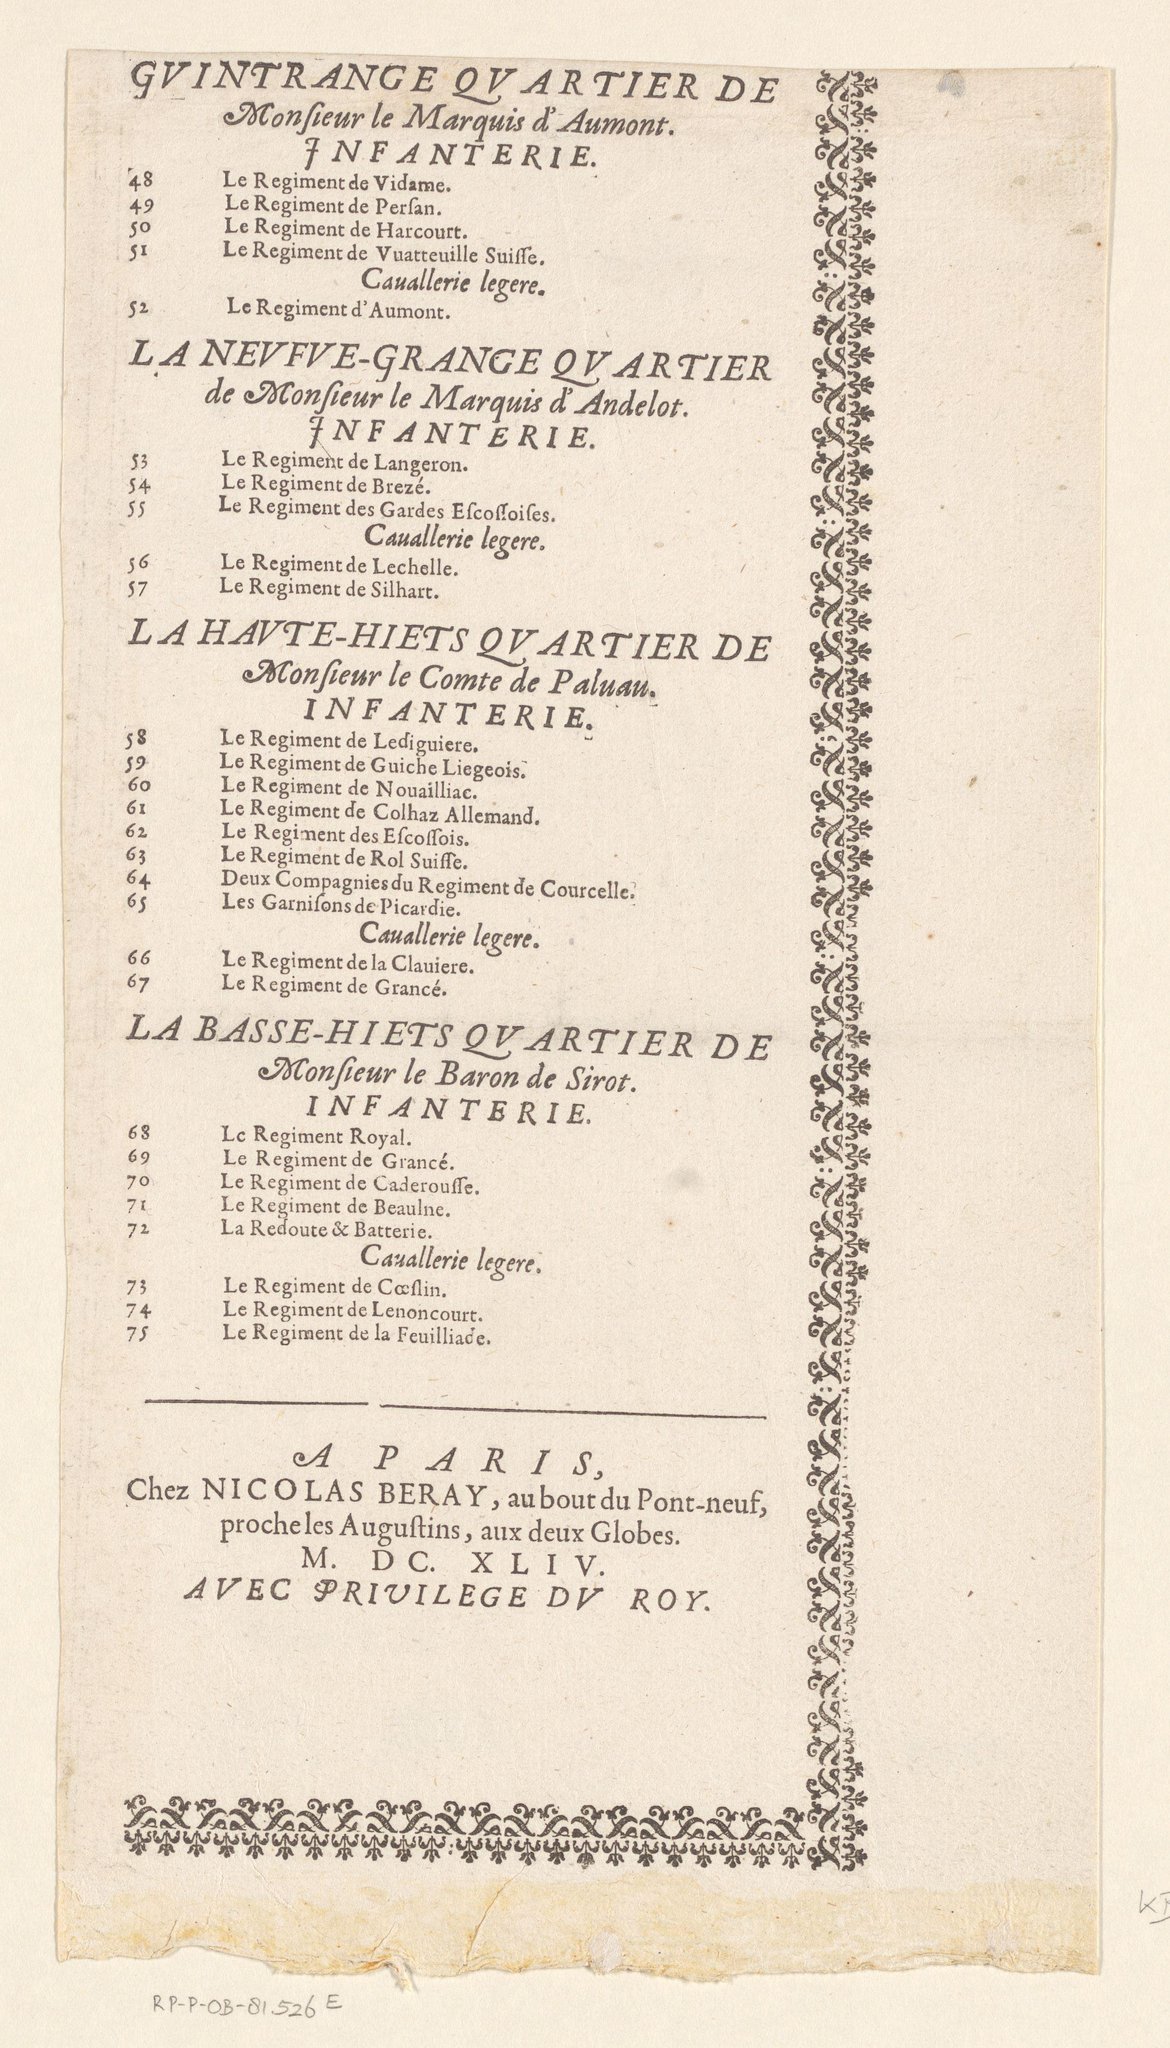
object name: map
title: Tekstblad bij de kaart van het beleg van Thionville, 1643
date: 1644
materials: paper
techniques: letterpress printing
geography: paris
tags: lodewijk xiv (koning van frankrijk), paris, lodewijk ii de bourbon-condé (hertog van enghien)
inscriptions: collector's mark: Lugt 240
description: Tekstblad bij de kaart van de belegering van Thionville door het Franse leger onder bevel van Lodewijk II van Bourbon-Condé, de hertog van Enghien, 18 juni - 10 augustus 1643. Tekstblad met een lijst van de Franse regimenten (nrs. 48-75) in het Frans. Met ornamentele rand. Onderdeel (rechtsonder) van een ongemonteerd ensemble bestaande uit de kaart van het beleg en vier tekstbladen.